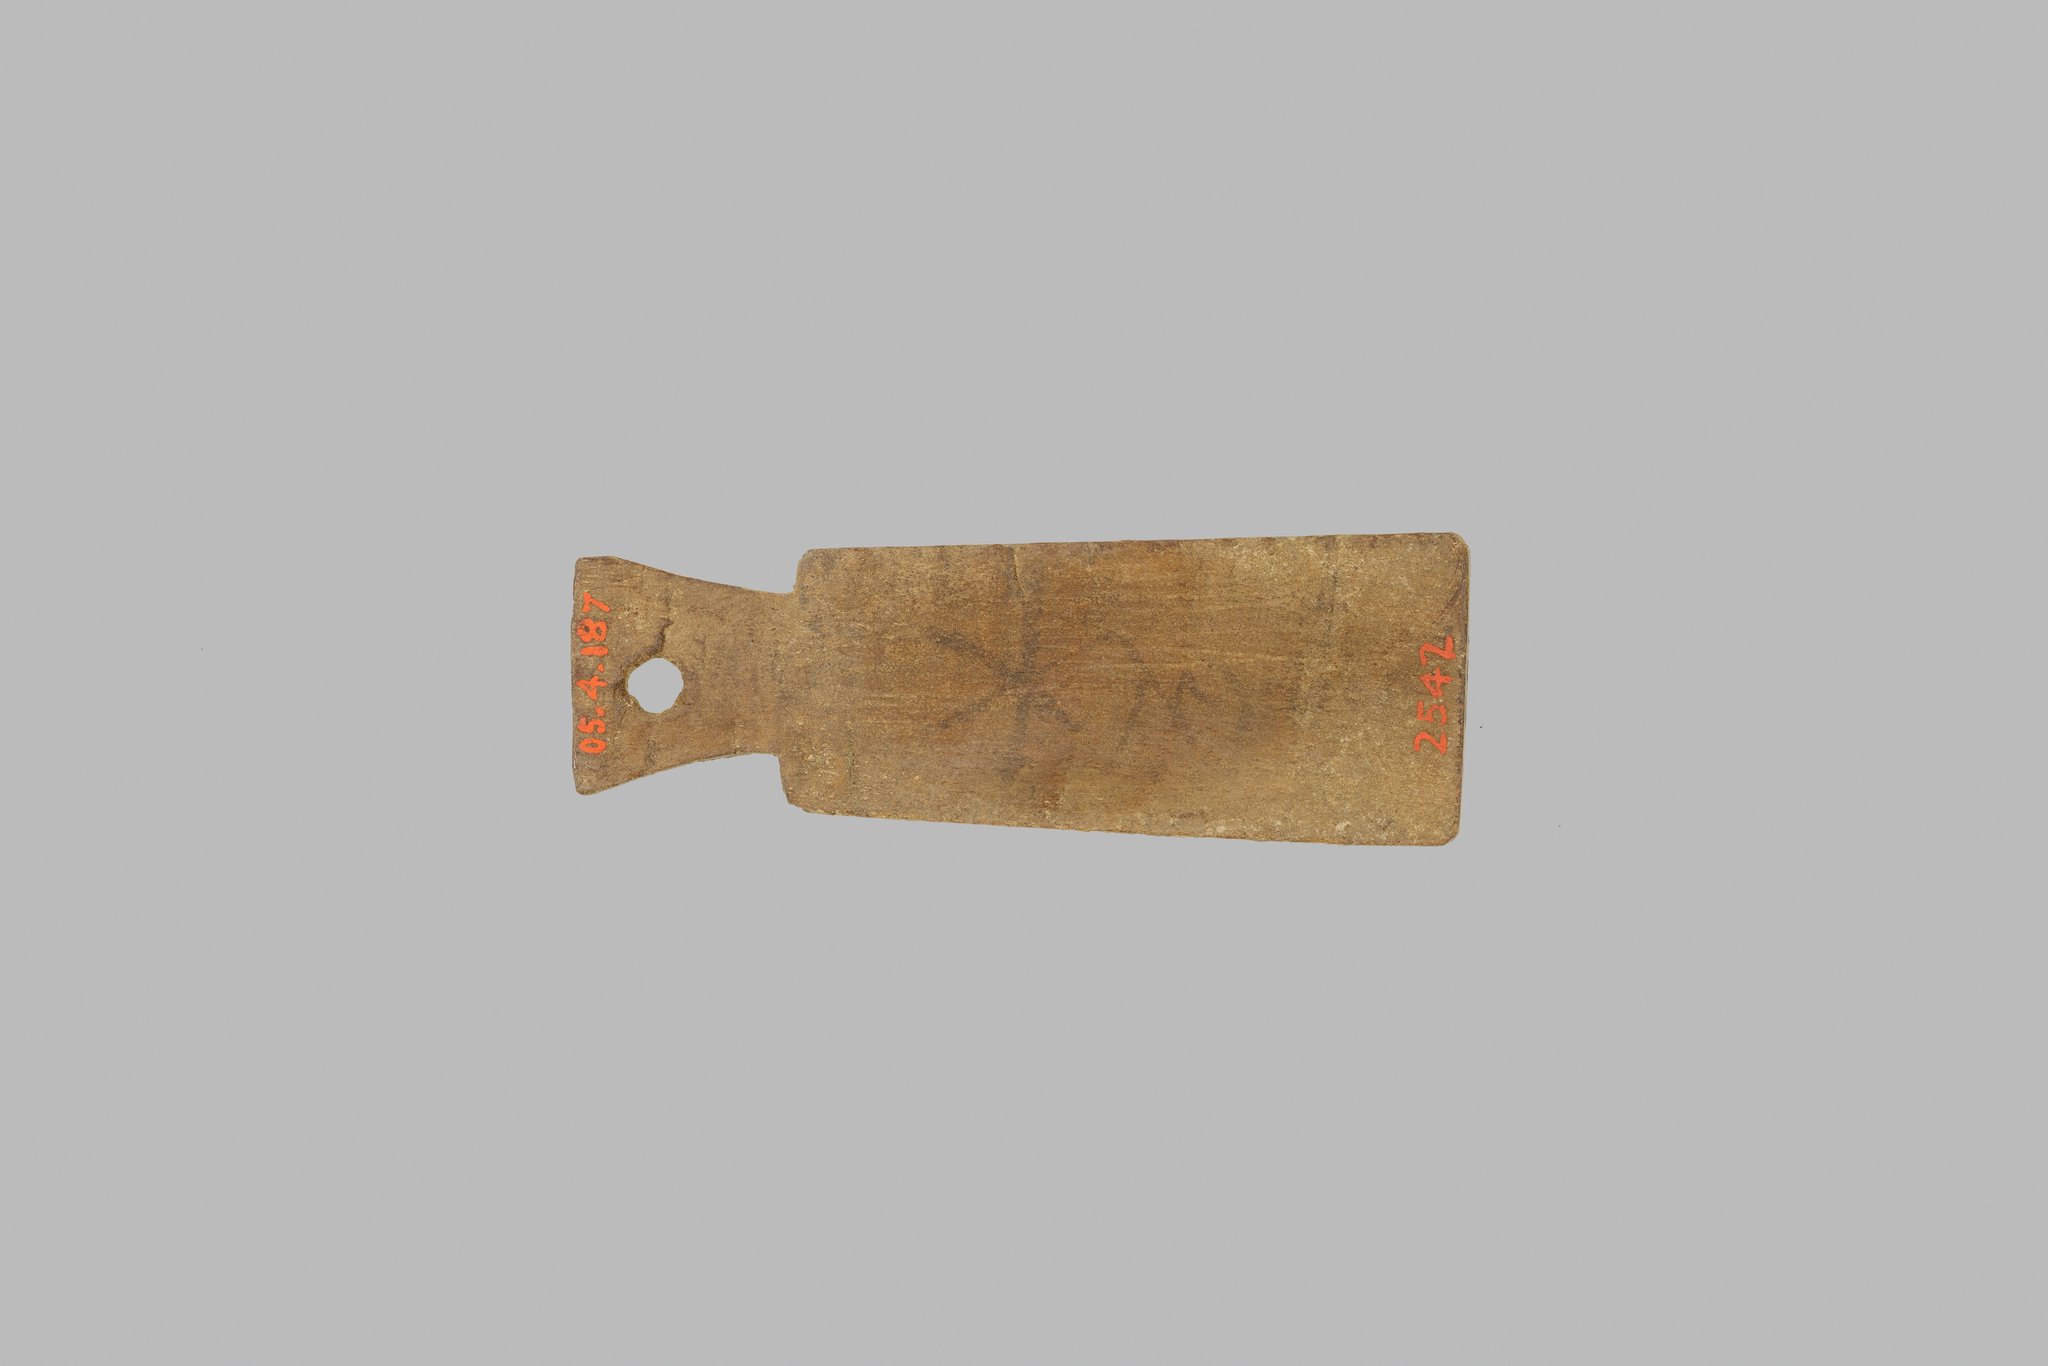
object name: mummy label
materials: ink, wood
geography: egypt